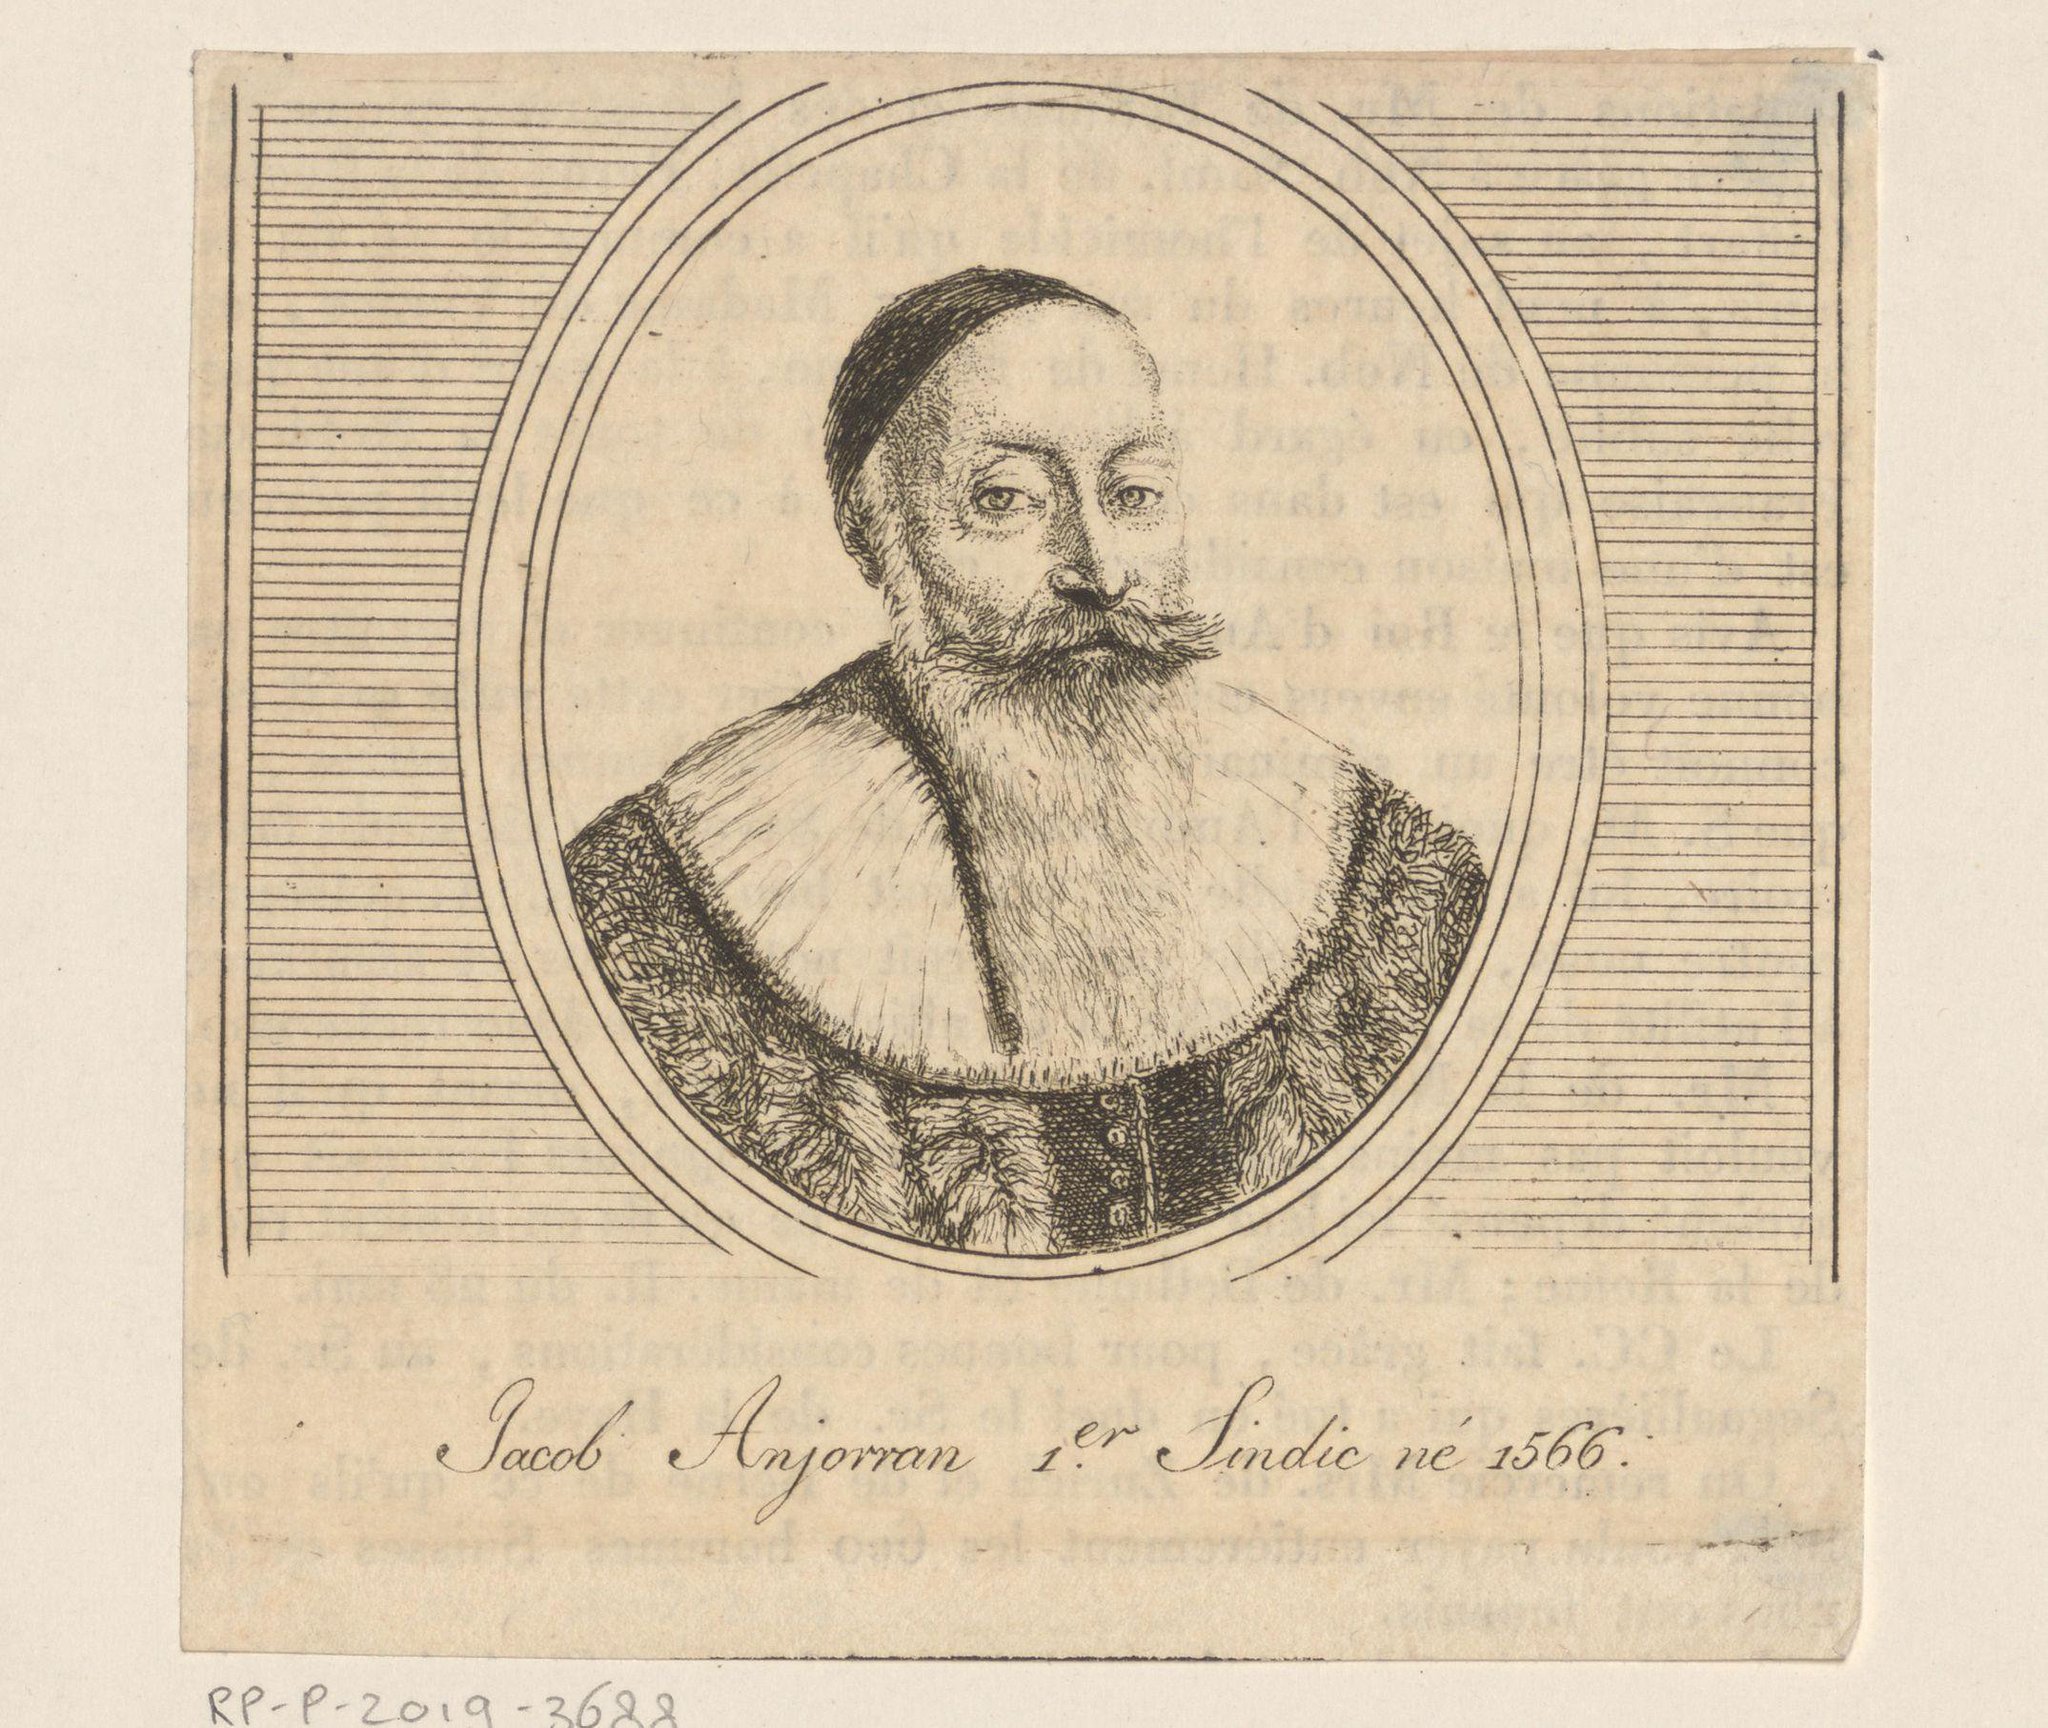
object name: print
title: Portret van Jacob Anjorran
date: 1815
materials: paper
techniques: etching, letterpress printing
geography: geneva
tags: historical persons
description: Prent uit: Fragmens biographiques et historiques, extraits des registres du conseil d'état de la République de Genève (...). Genève: Manget en Cherbuliez, 1815, p. 101.